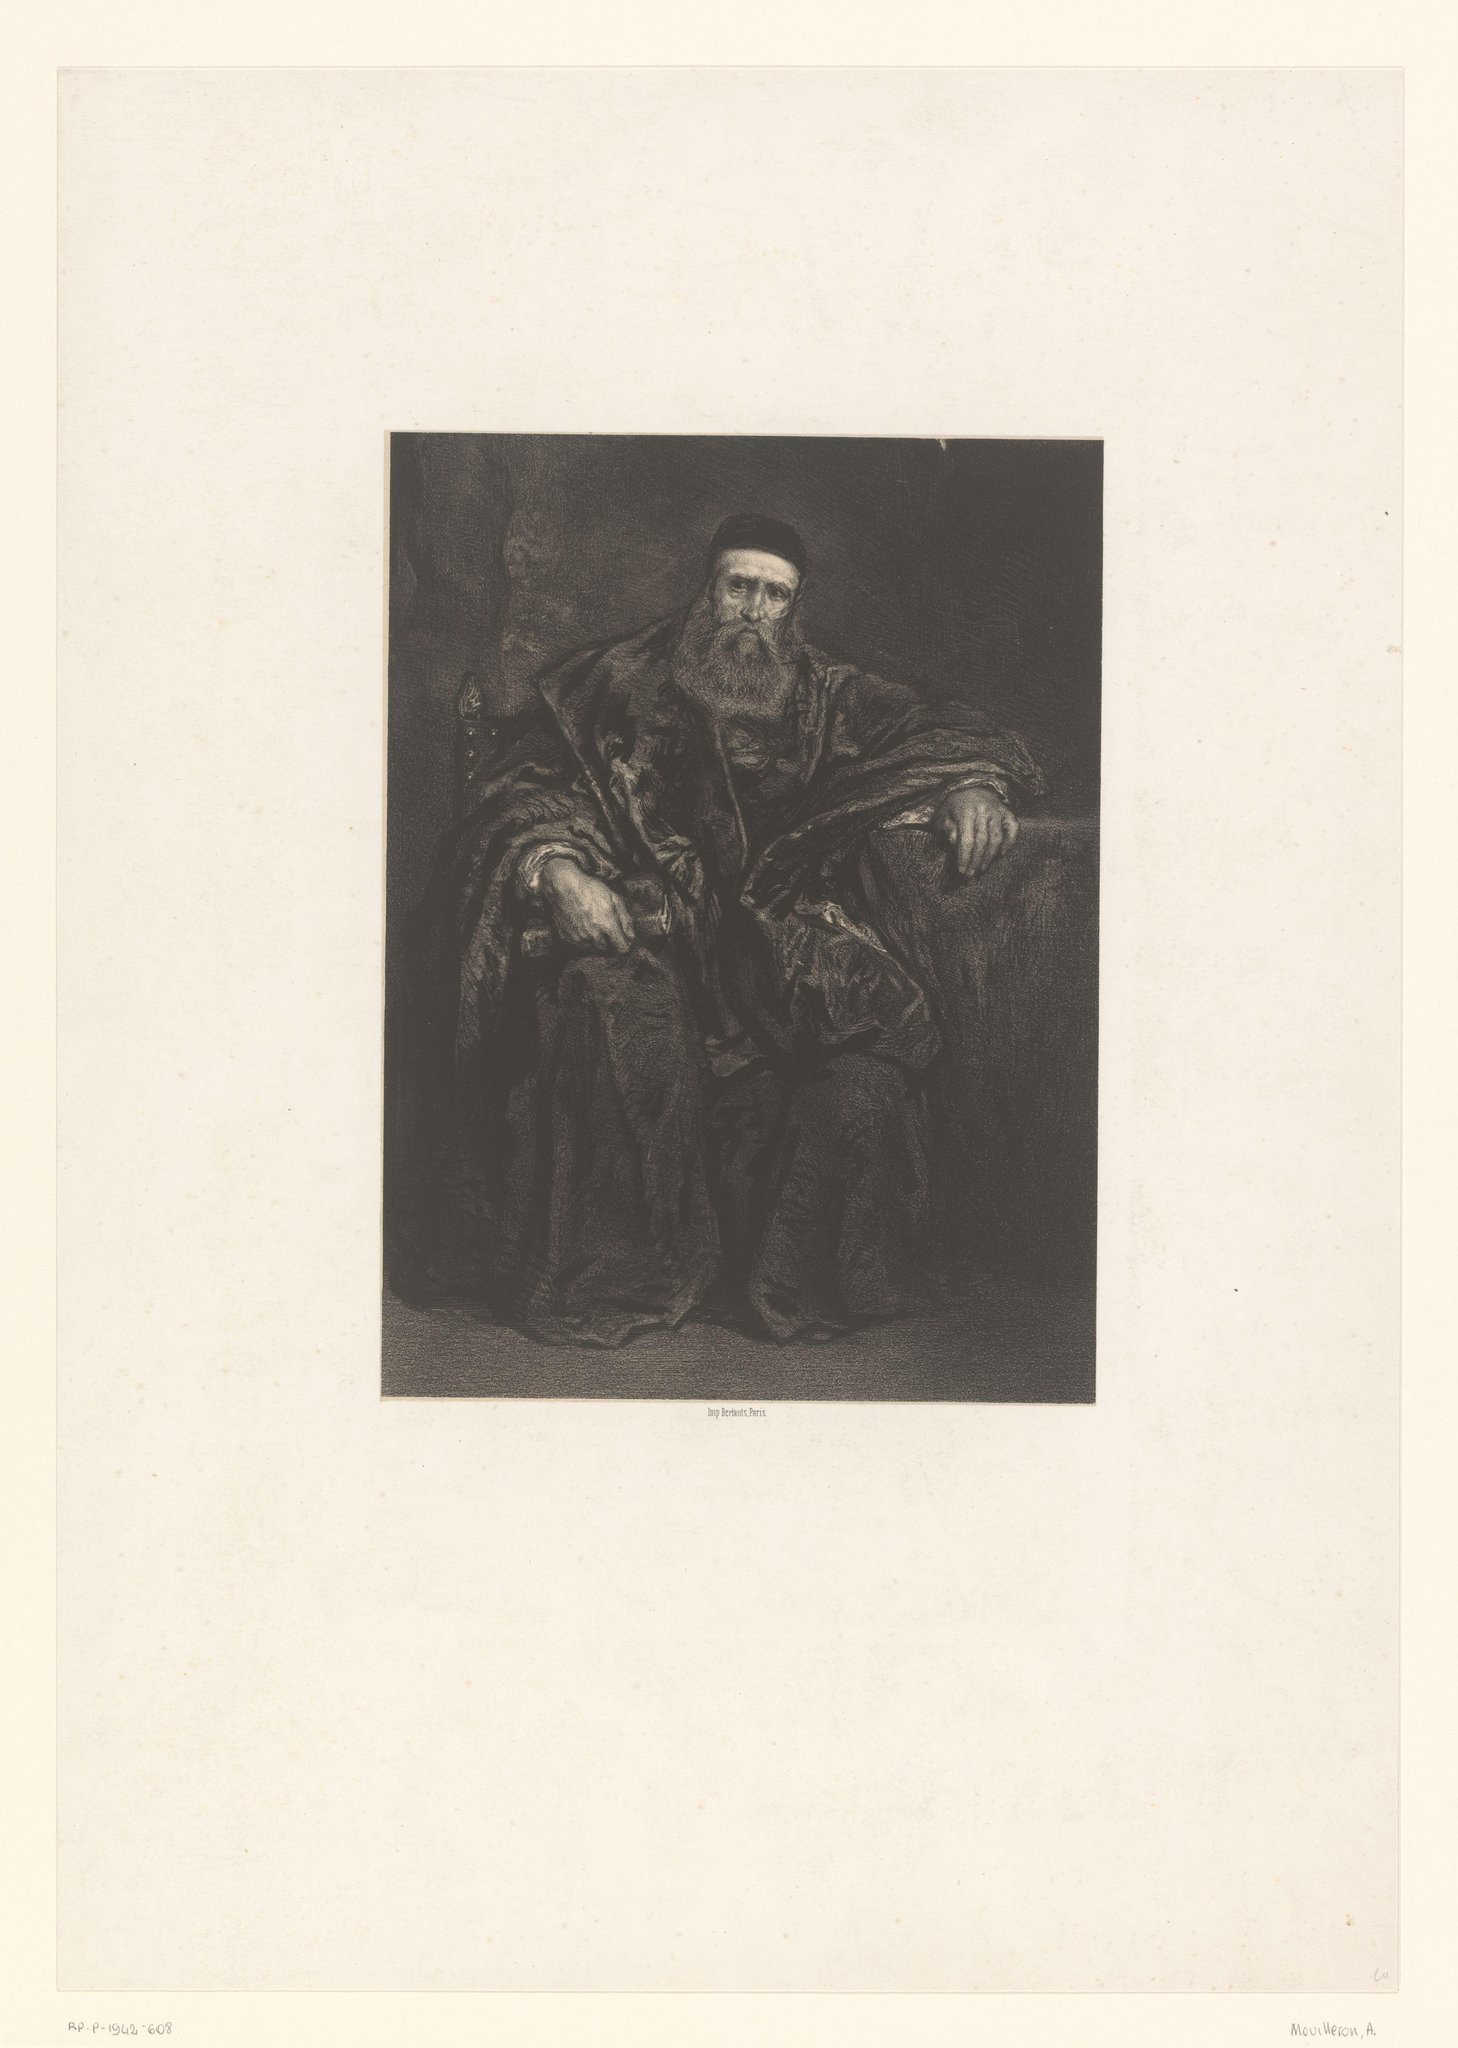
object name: print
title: Zittende man met baard en ruime, donkere mantel houdt een gesloten boek vast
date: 1830-1880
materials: paper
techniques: lithograph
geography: paris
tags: sitting figure, adult man, historical persons, book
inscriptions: collector's mark: Lugt 2228